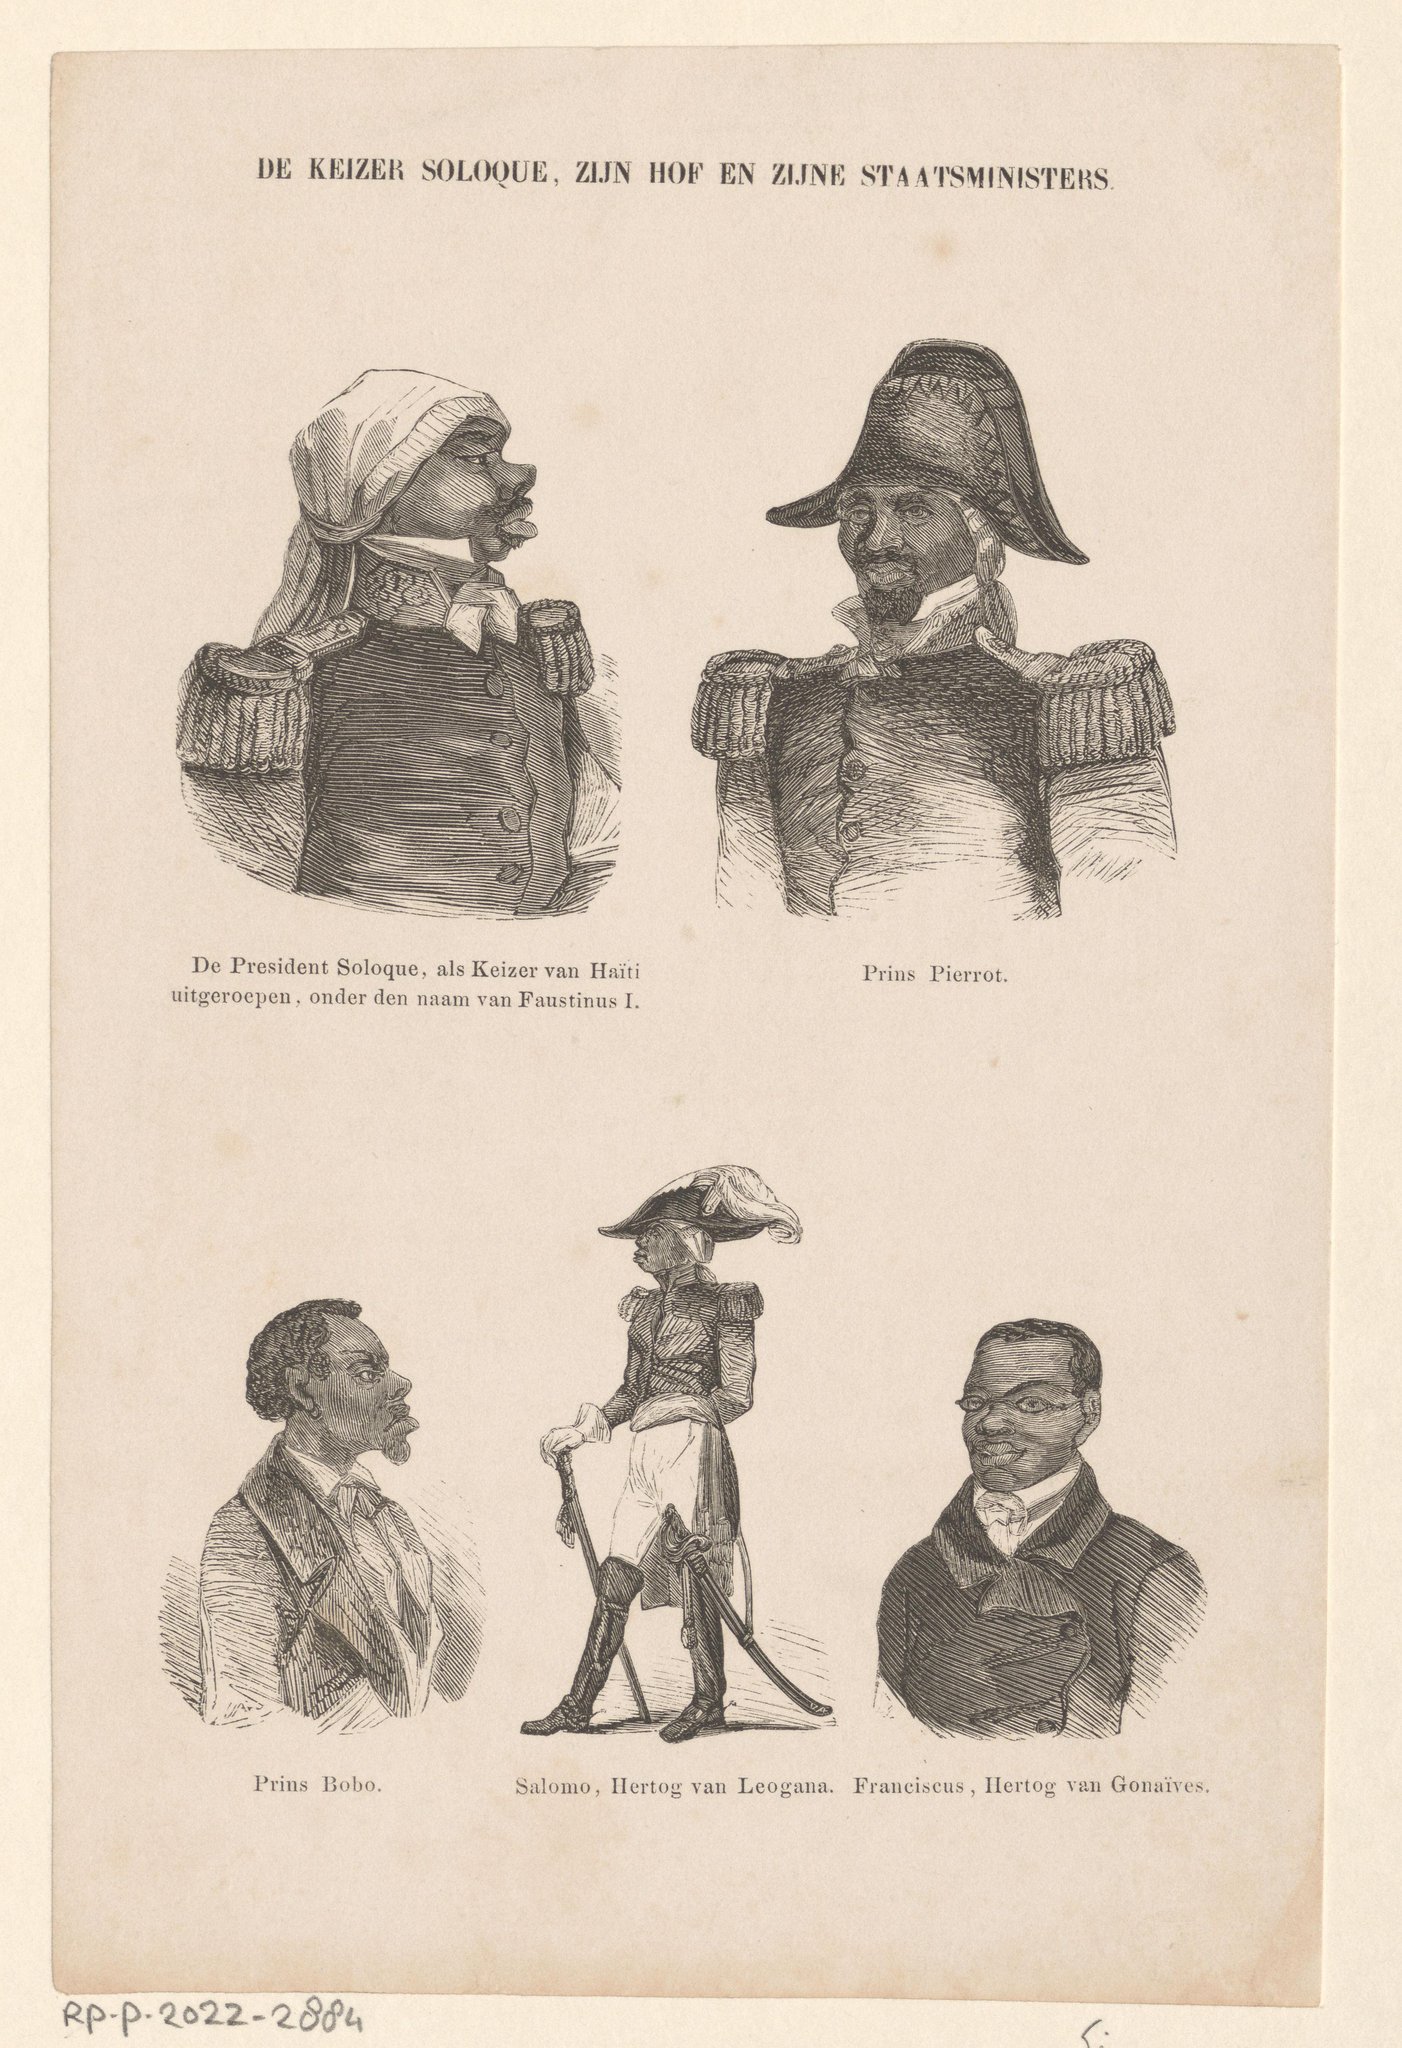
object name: print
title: Portretten van Faustin Soulouque, Jean-Louis Pierrot, Prins Bobo, Salomo, hertog van Léogâne en Franciscus, hertog van Gonaïves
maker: Anonymous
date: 1849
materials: paper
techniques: letterpress printing, engraving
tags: politician, historical person (with name) - historical person (with name) portrayed in a group, in a group-portrait, ministerial council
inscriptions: collector's mark: Lugt 2228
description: Prent waarschijnlijk uit: De tijdspiegel. Den Haag: K. Fuhri, dl. 2, 1849.